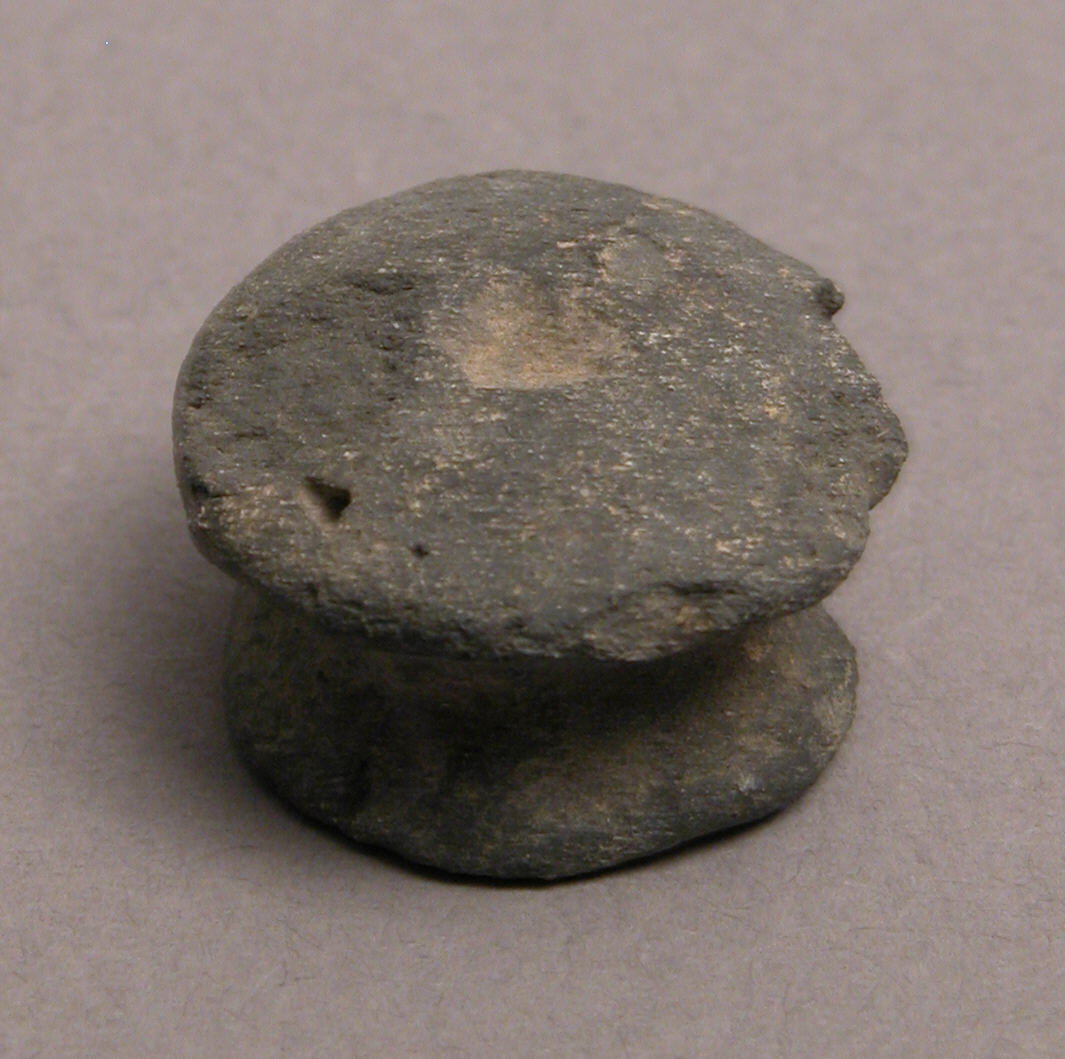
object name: game piece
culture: coptic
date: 301-700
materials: earthenware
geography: egypt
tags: games